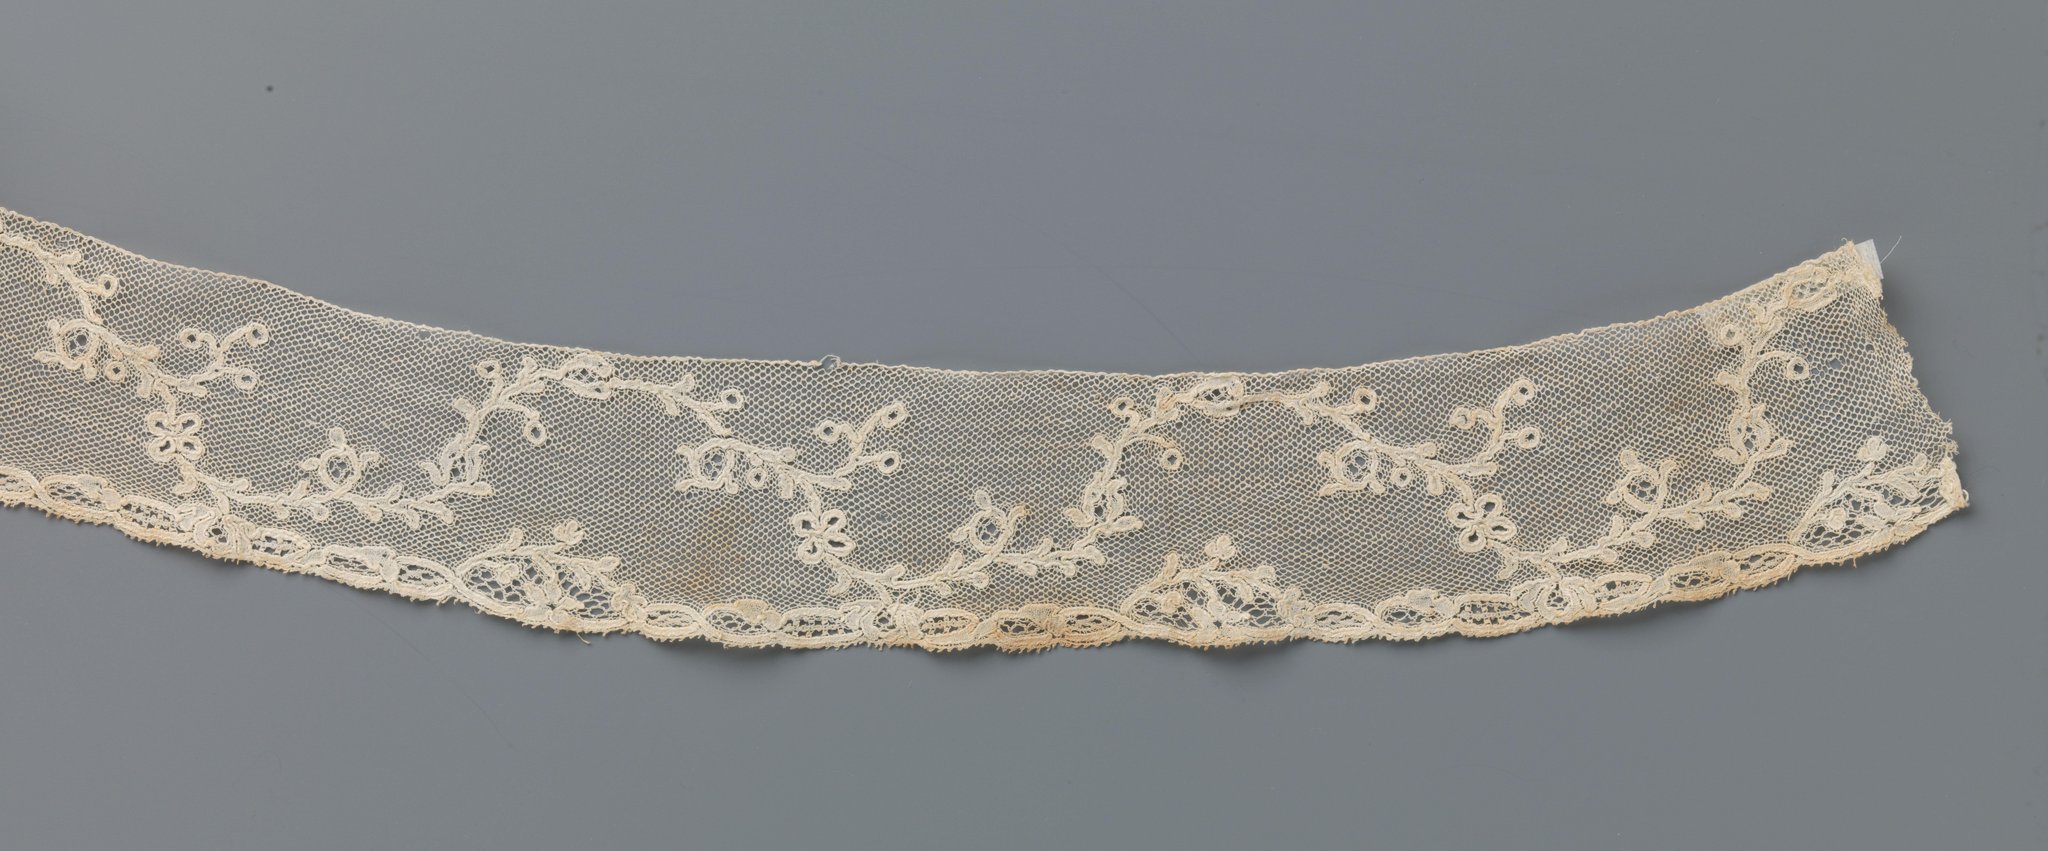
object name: strip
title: Strook kloskant met doorlopende golvende rank met besjes en vlinder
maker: Anonymous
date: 1770-1780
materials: linen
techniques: lace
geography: mechelen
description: Strook naturelkleurige kloskant: Mechelse kant. Het zich herhalende patroon bestaat uit een doorlopende en golvende rank met kleine blaadjes aan weerskanten, een enkele korte aftakking met een besje eraan en enkele bloempjes. Aan het begin van elke golftop zit een vlinder of vlindervormige bloem, de rank maakt binnen één golf twee keer een lusje. De flauw geschulpte onderzijde wordt gevormd door een dubbele smalle slinger, die een aaneenschakeling van spitsovaalvormige cartouches vormt. Onder elke golftop bevindt zich steeds een grotere cartouche in het patroon langs de onderrand, met een bladertakje en een stervormig bloempje. De motieven zijn met elkaar verbonden door een fijne maasgrond, de Mechelse grond. De motieven zijn gemaakt in linnenslag met dikkere en glimmende contourdraden. Er zijn verschillende siergronden toegepast in de cartouches langs de onderzijde, in de lusjes, besjes en bloemharten. De flauw geschulpte onderzijde komt voort uit het patroon met de dubbele slinger en is afgewerkt met picots. De bovenzijde is afgewerkt met een apart geklost recht bandje.